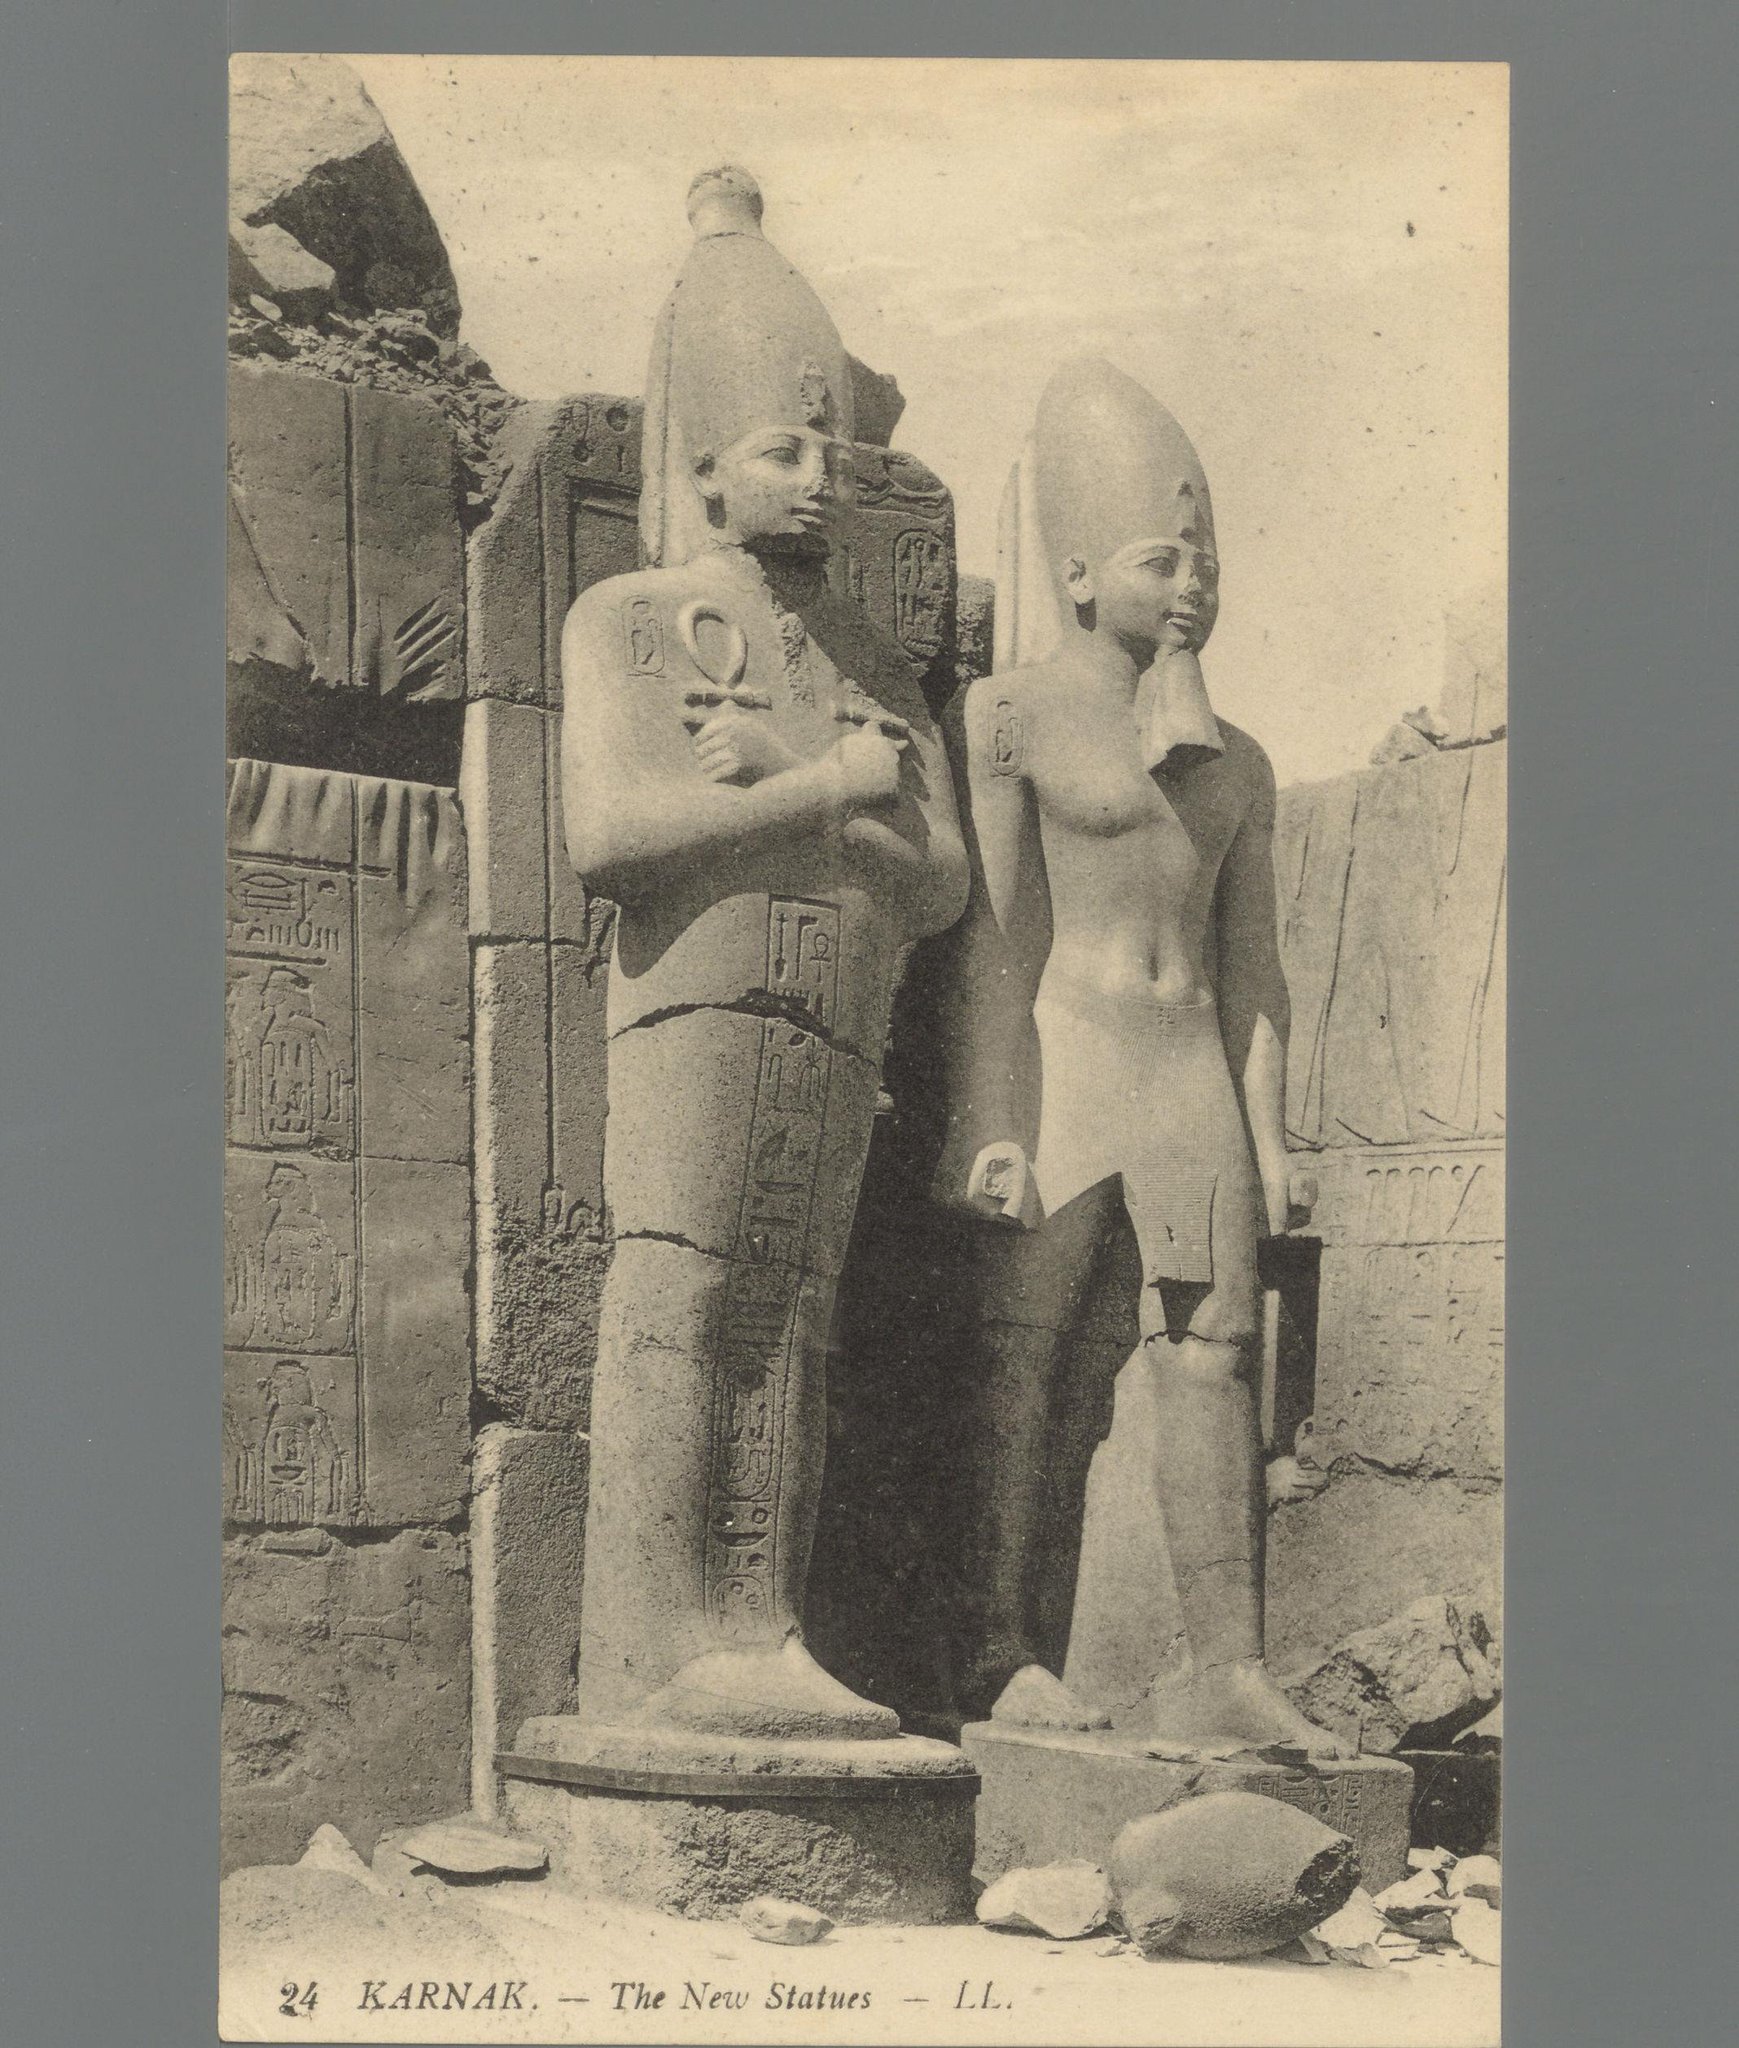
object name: ansichtkaart, prentbriefkaart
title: Karnak - The new statues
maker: Anonymous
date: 1907-1930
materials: cardboard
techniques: photograph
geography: paris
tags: temple, shrine ~ egyptian religion, statues, paintings, etc. ~ objects of worship (egyptian religion)